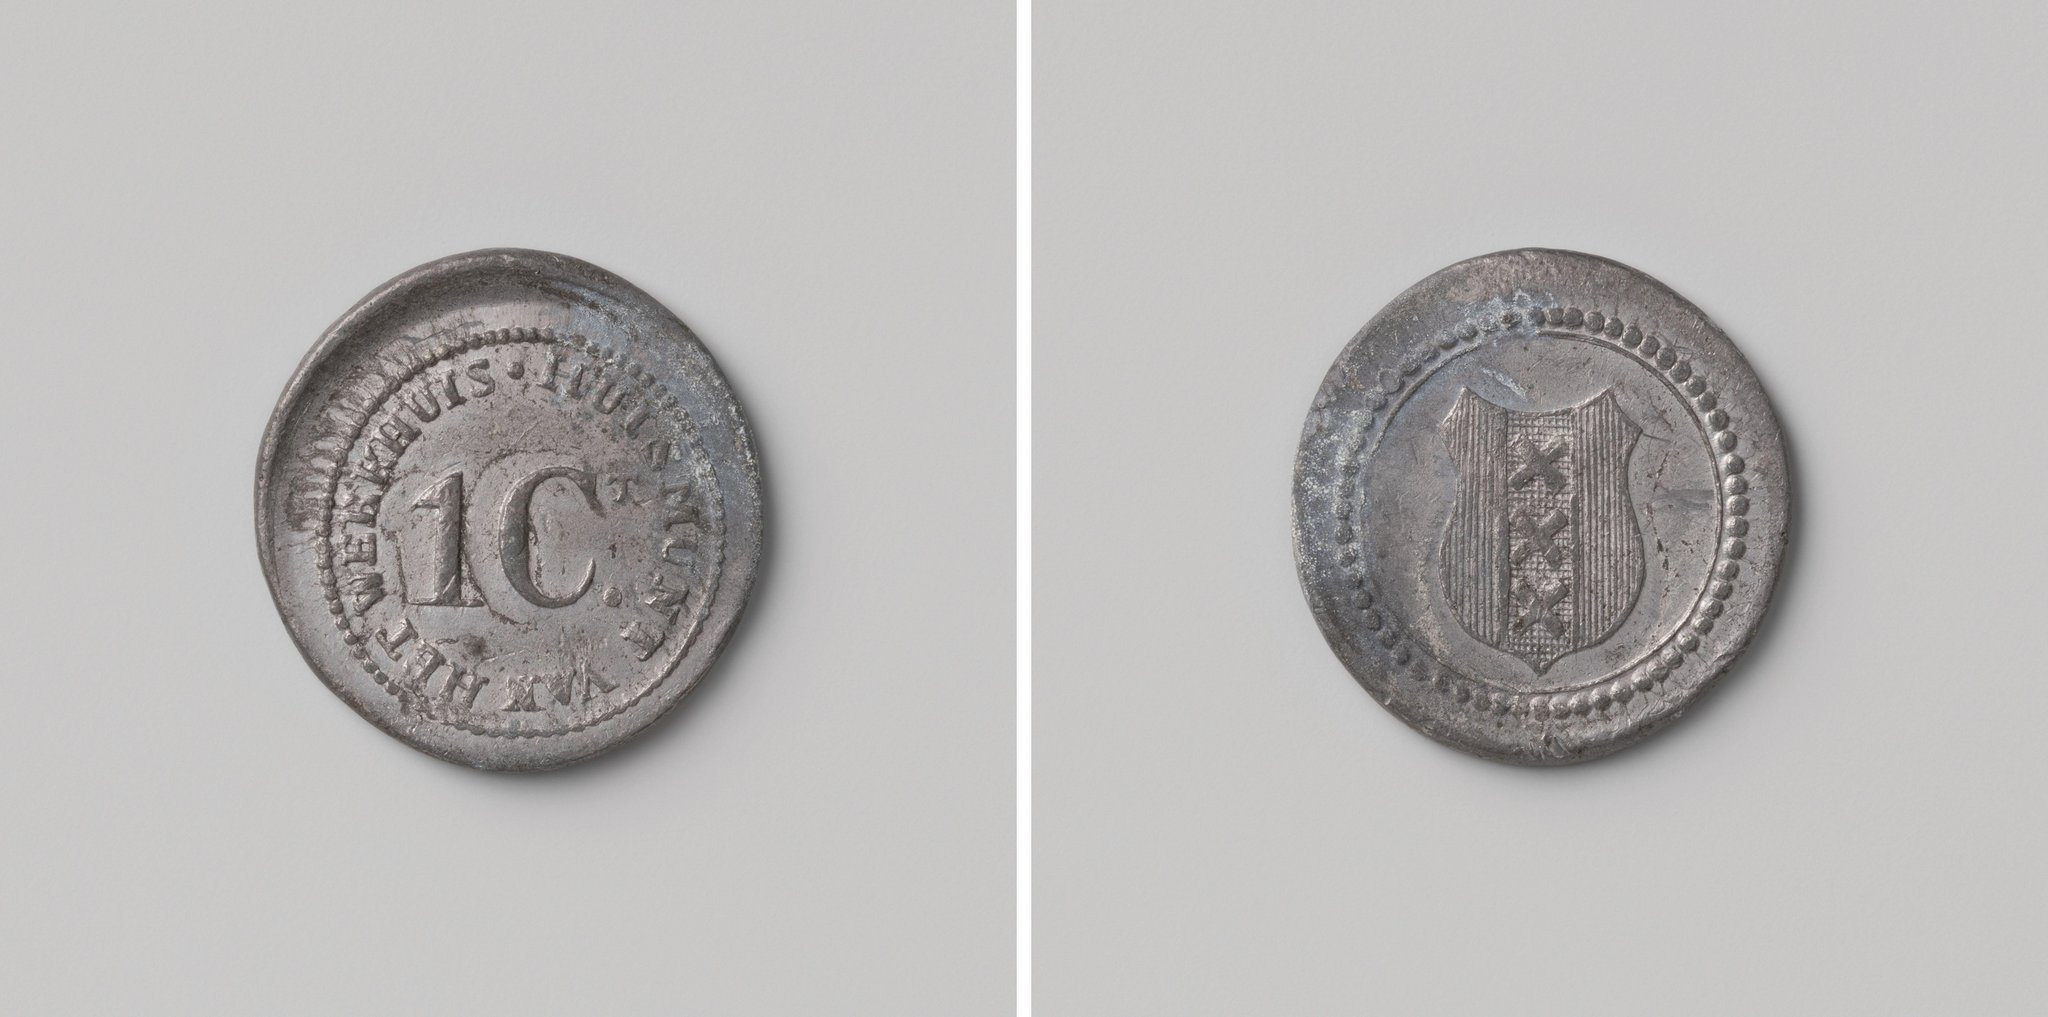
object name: cent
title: Werkhuis te Amsterdam, huismunt ter waarde van 1 cent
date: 1824-1837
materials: lead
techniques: striking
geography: amsterdam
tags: amsterdam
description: Voorzijde: waardeaanduiding binnen omschrift en parelrand. Keerzijde: wapenschild binnen parelrand